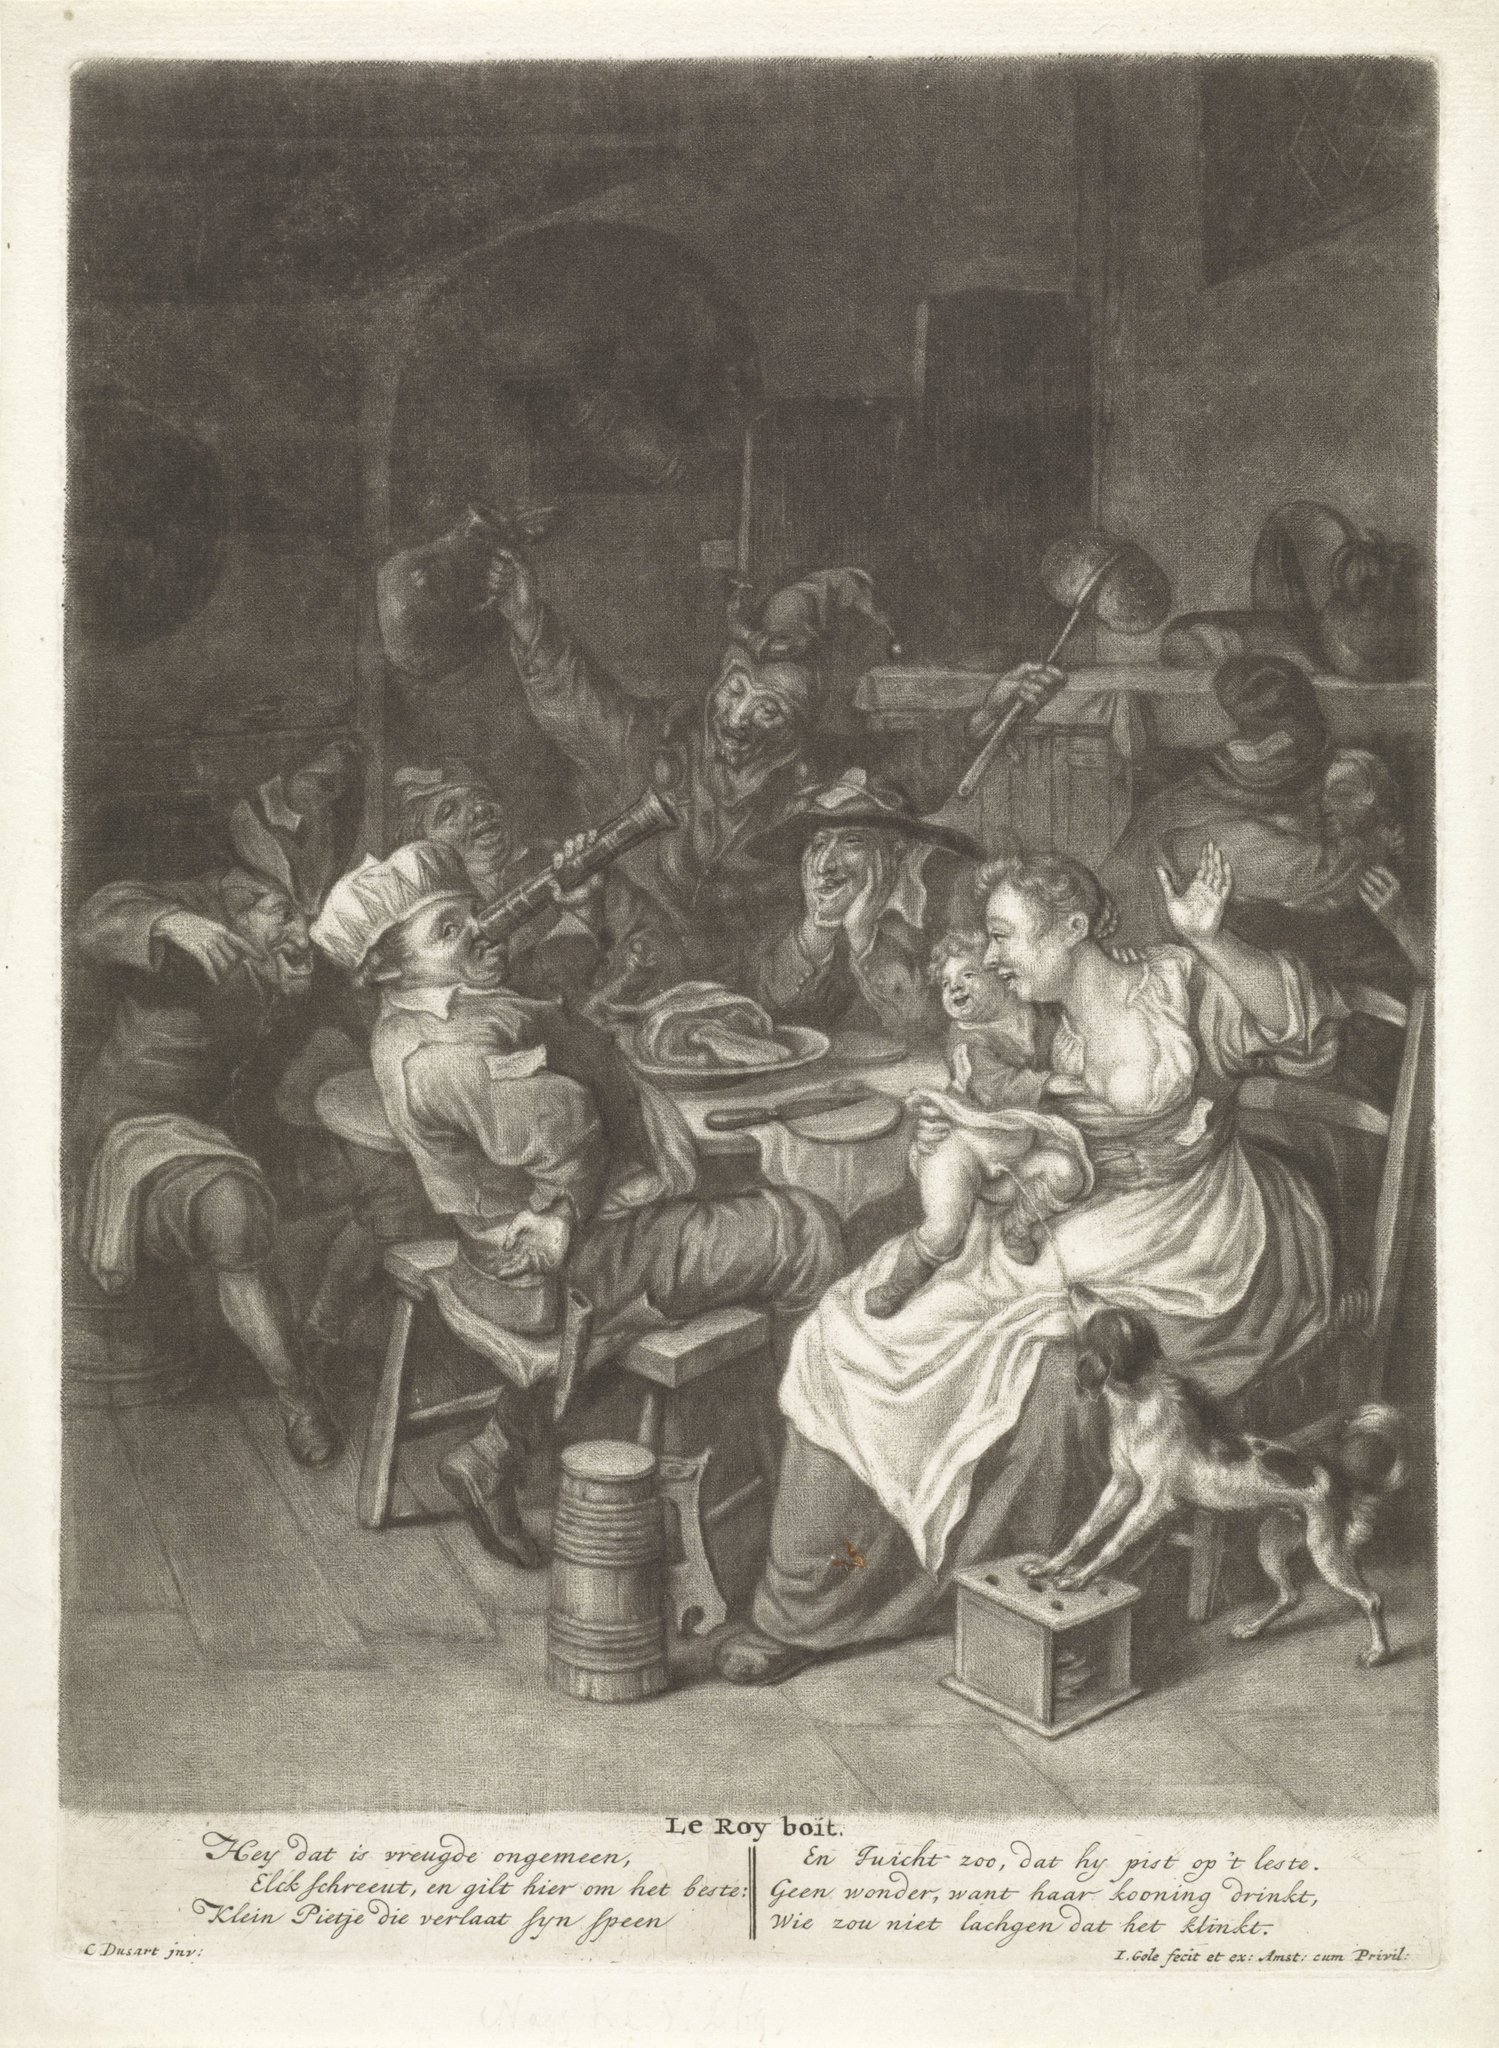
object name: print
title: Driekoningen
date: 1670-1724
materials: paper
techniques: engraving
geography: haarlem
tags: twelfth night, usually falling on the eve of january 6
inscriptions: collector's mark: Lugt 2228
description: Rond een eettafel viert een vrolijk gezelschap Driekoningen. De man met de koningsmuts op slaat een fluitglas drank achterover. Vanaf de schoot van zijn moeder plast een kind in de bek van een hond die met de voorpoten op een stoofje staat.